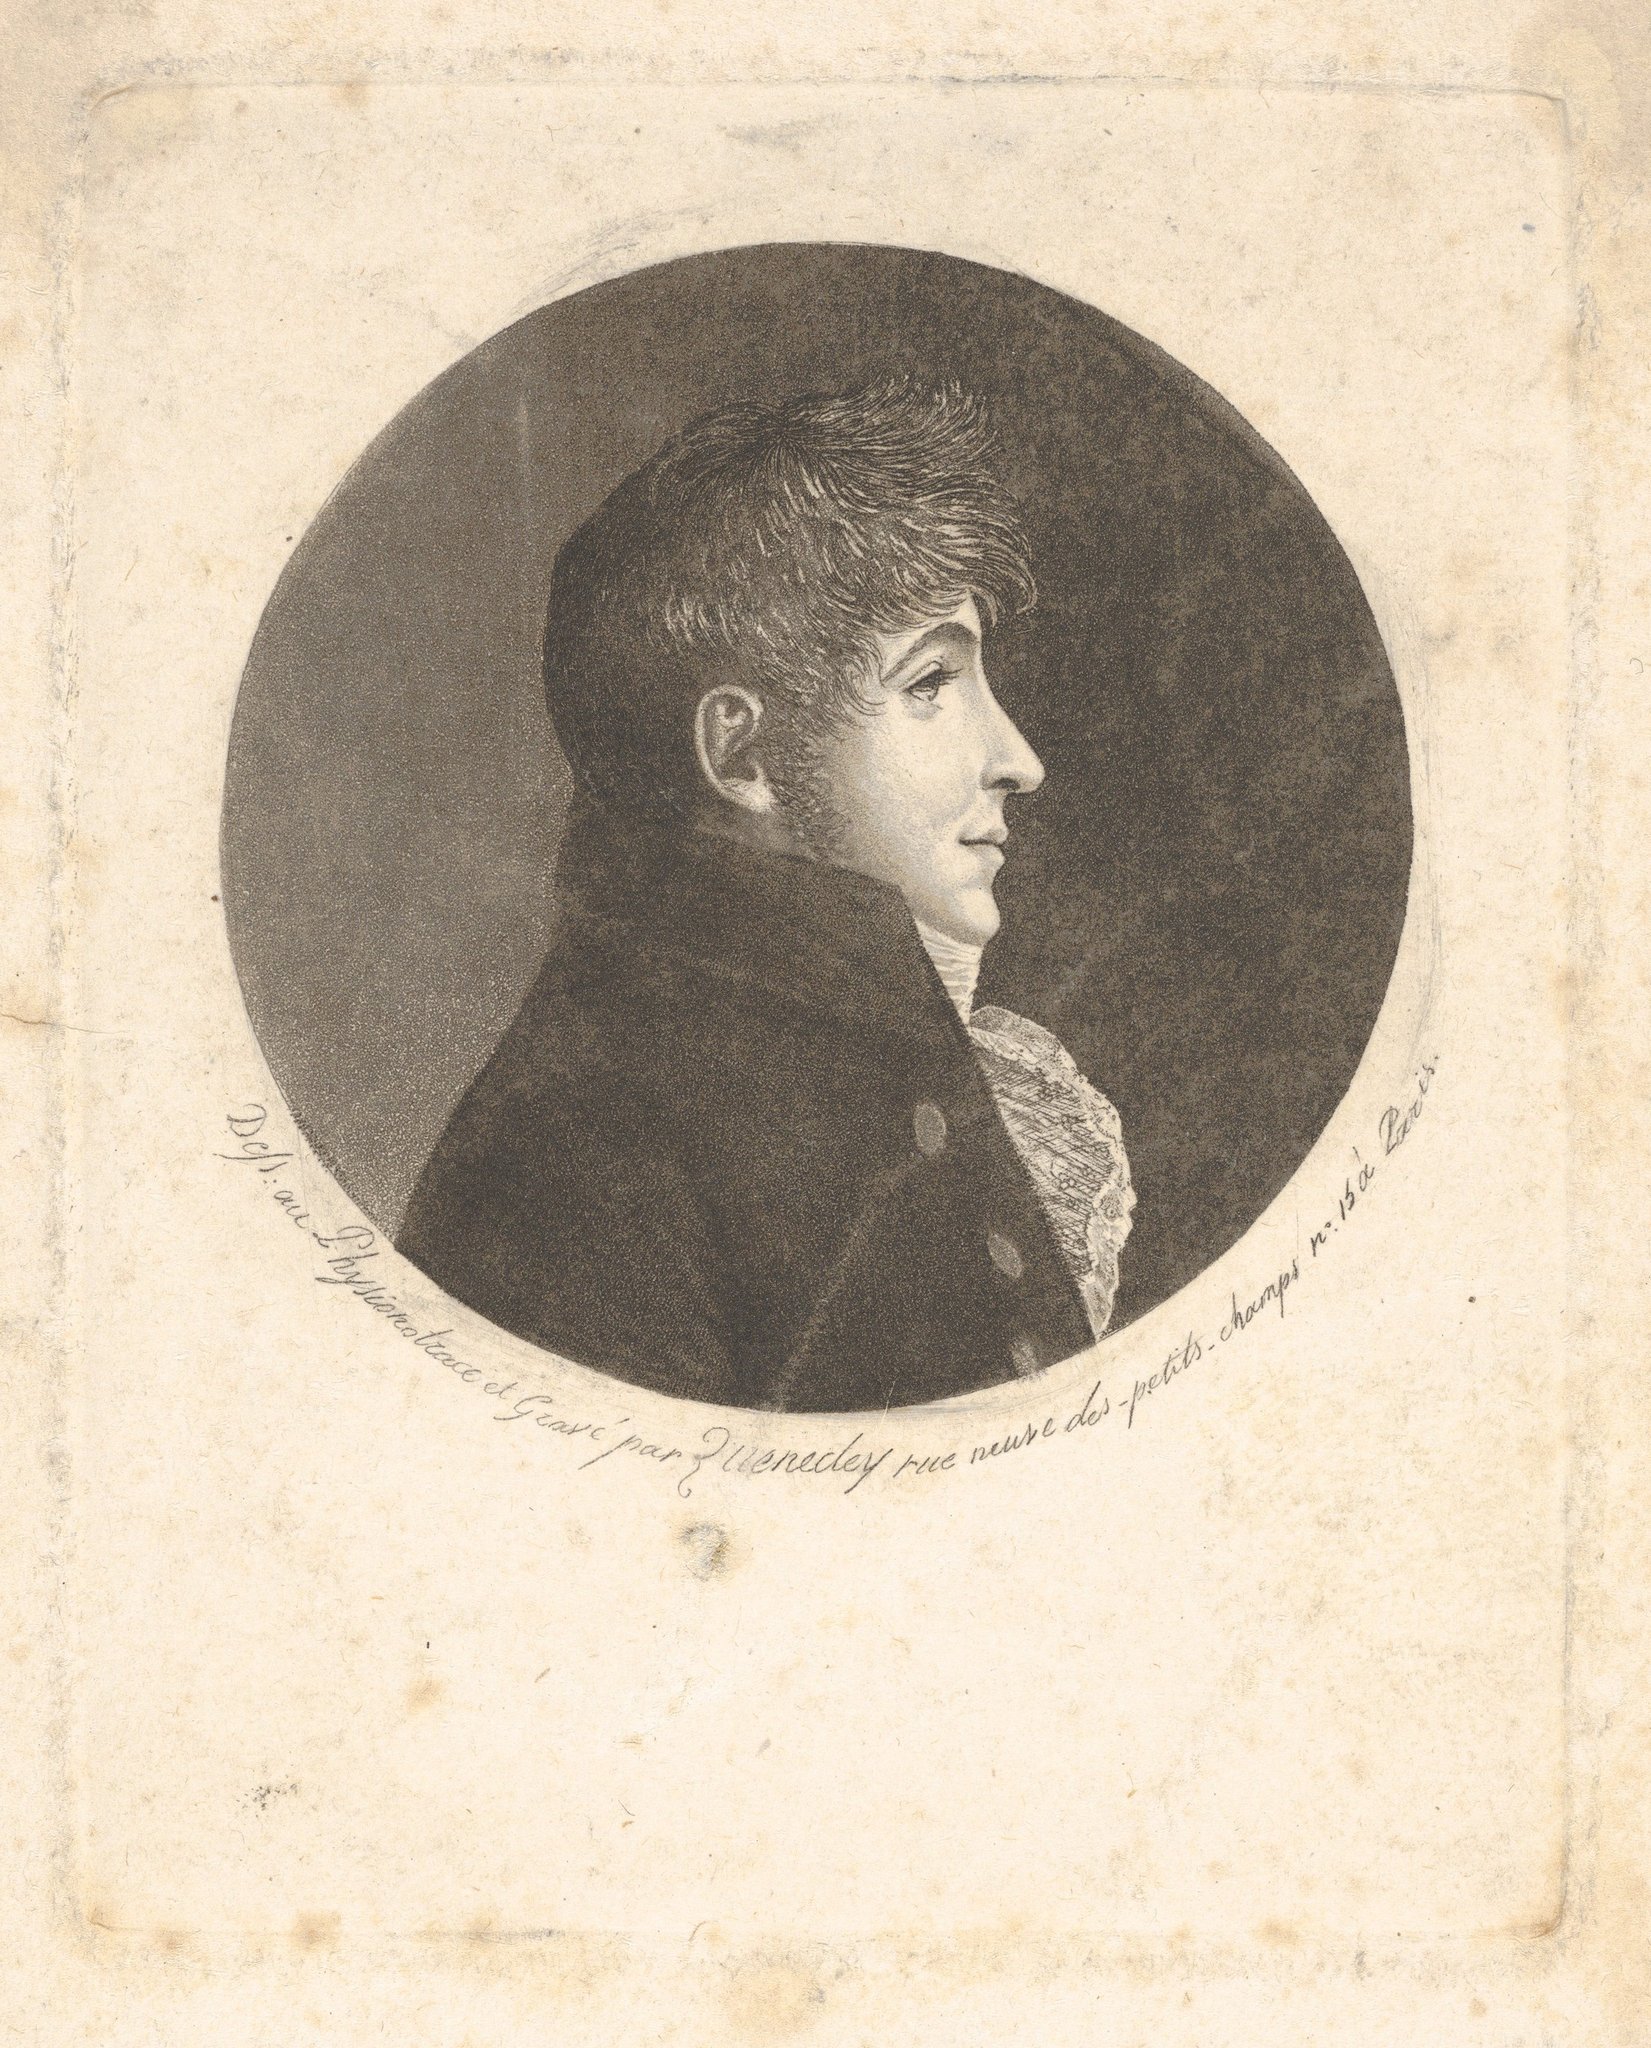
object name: print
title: Physionotrace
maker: edme quenedey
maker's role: artist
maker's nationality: french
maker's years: 1756-1830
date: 1608-1660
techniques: aquatint, etching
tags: men,profiles